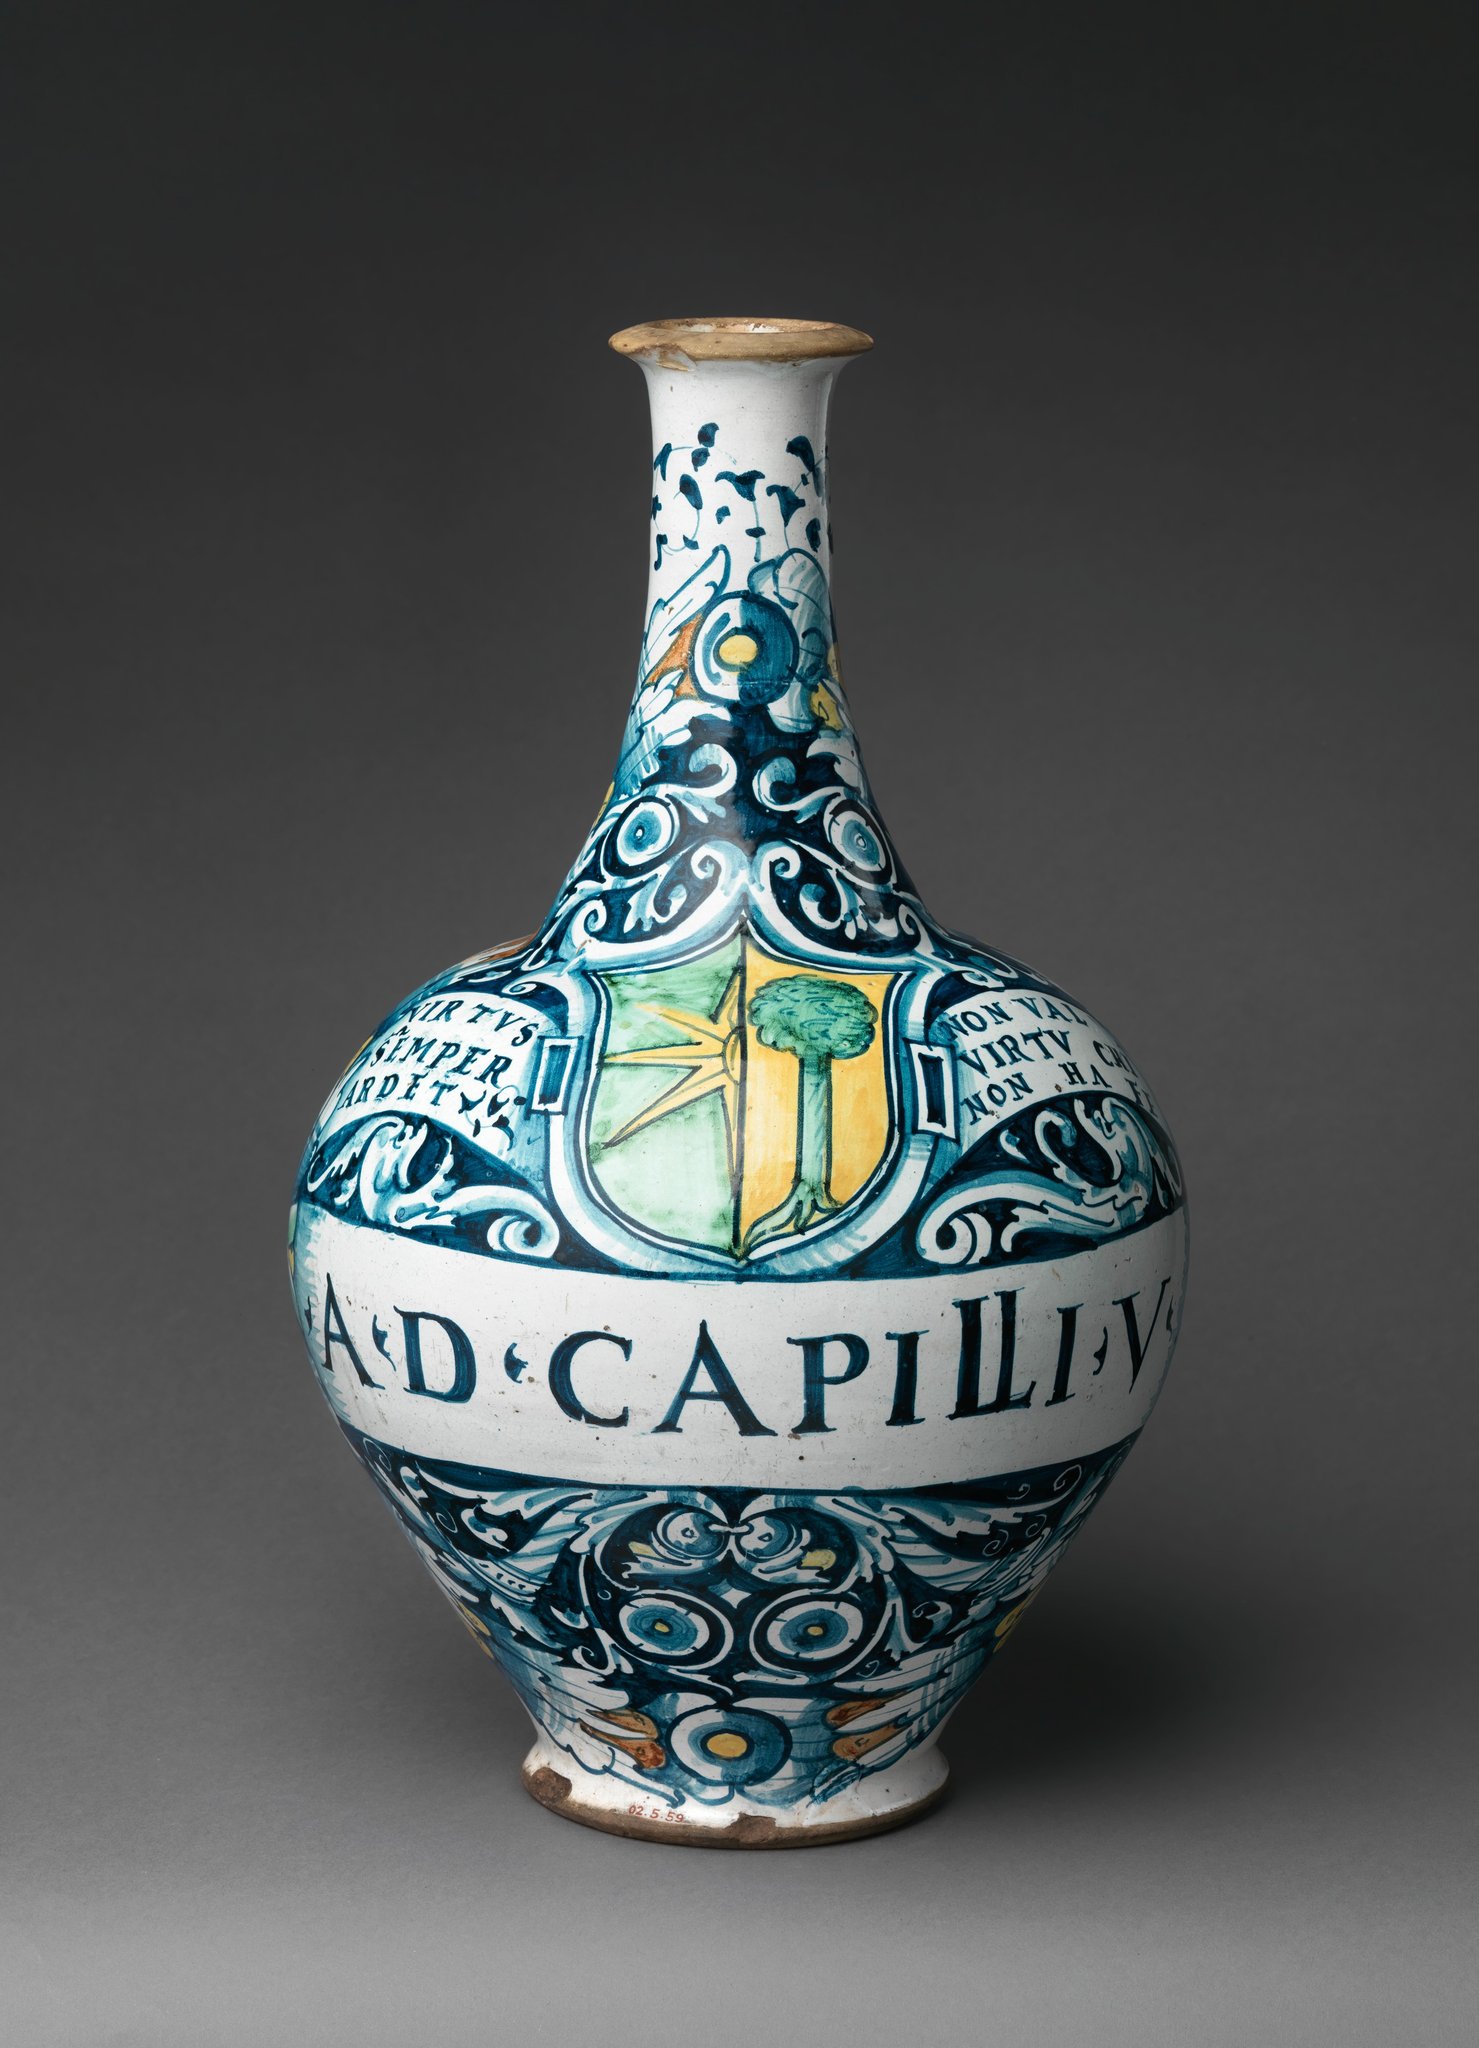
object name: pharmacy bottle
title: Pharmacy bottle (one of a pair)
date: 1500-1510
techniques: maiolica, glazing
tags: coat of arms